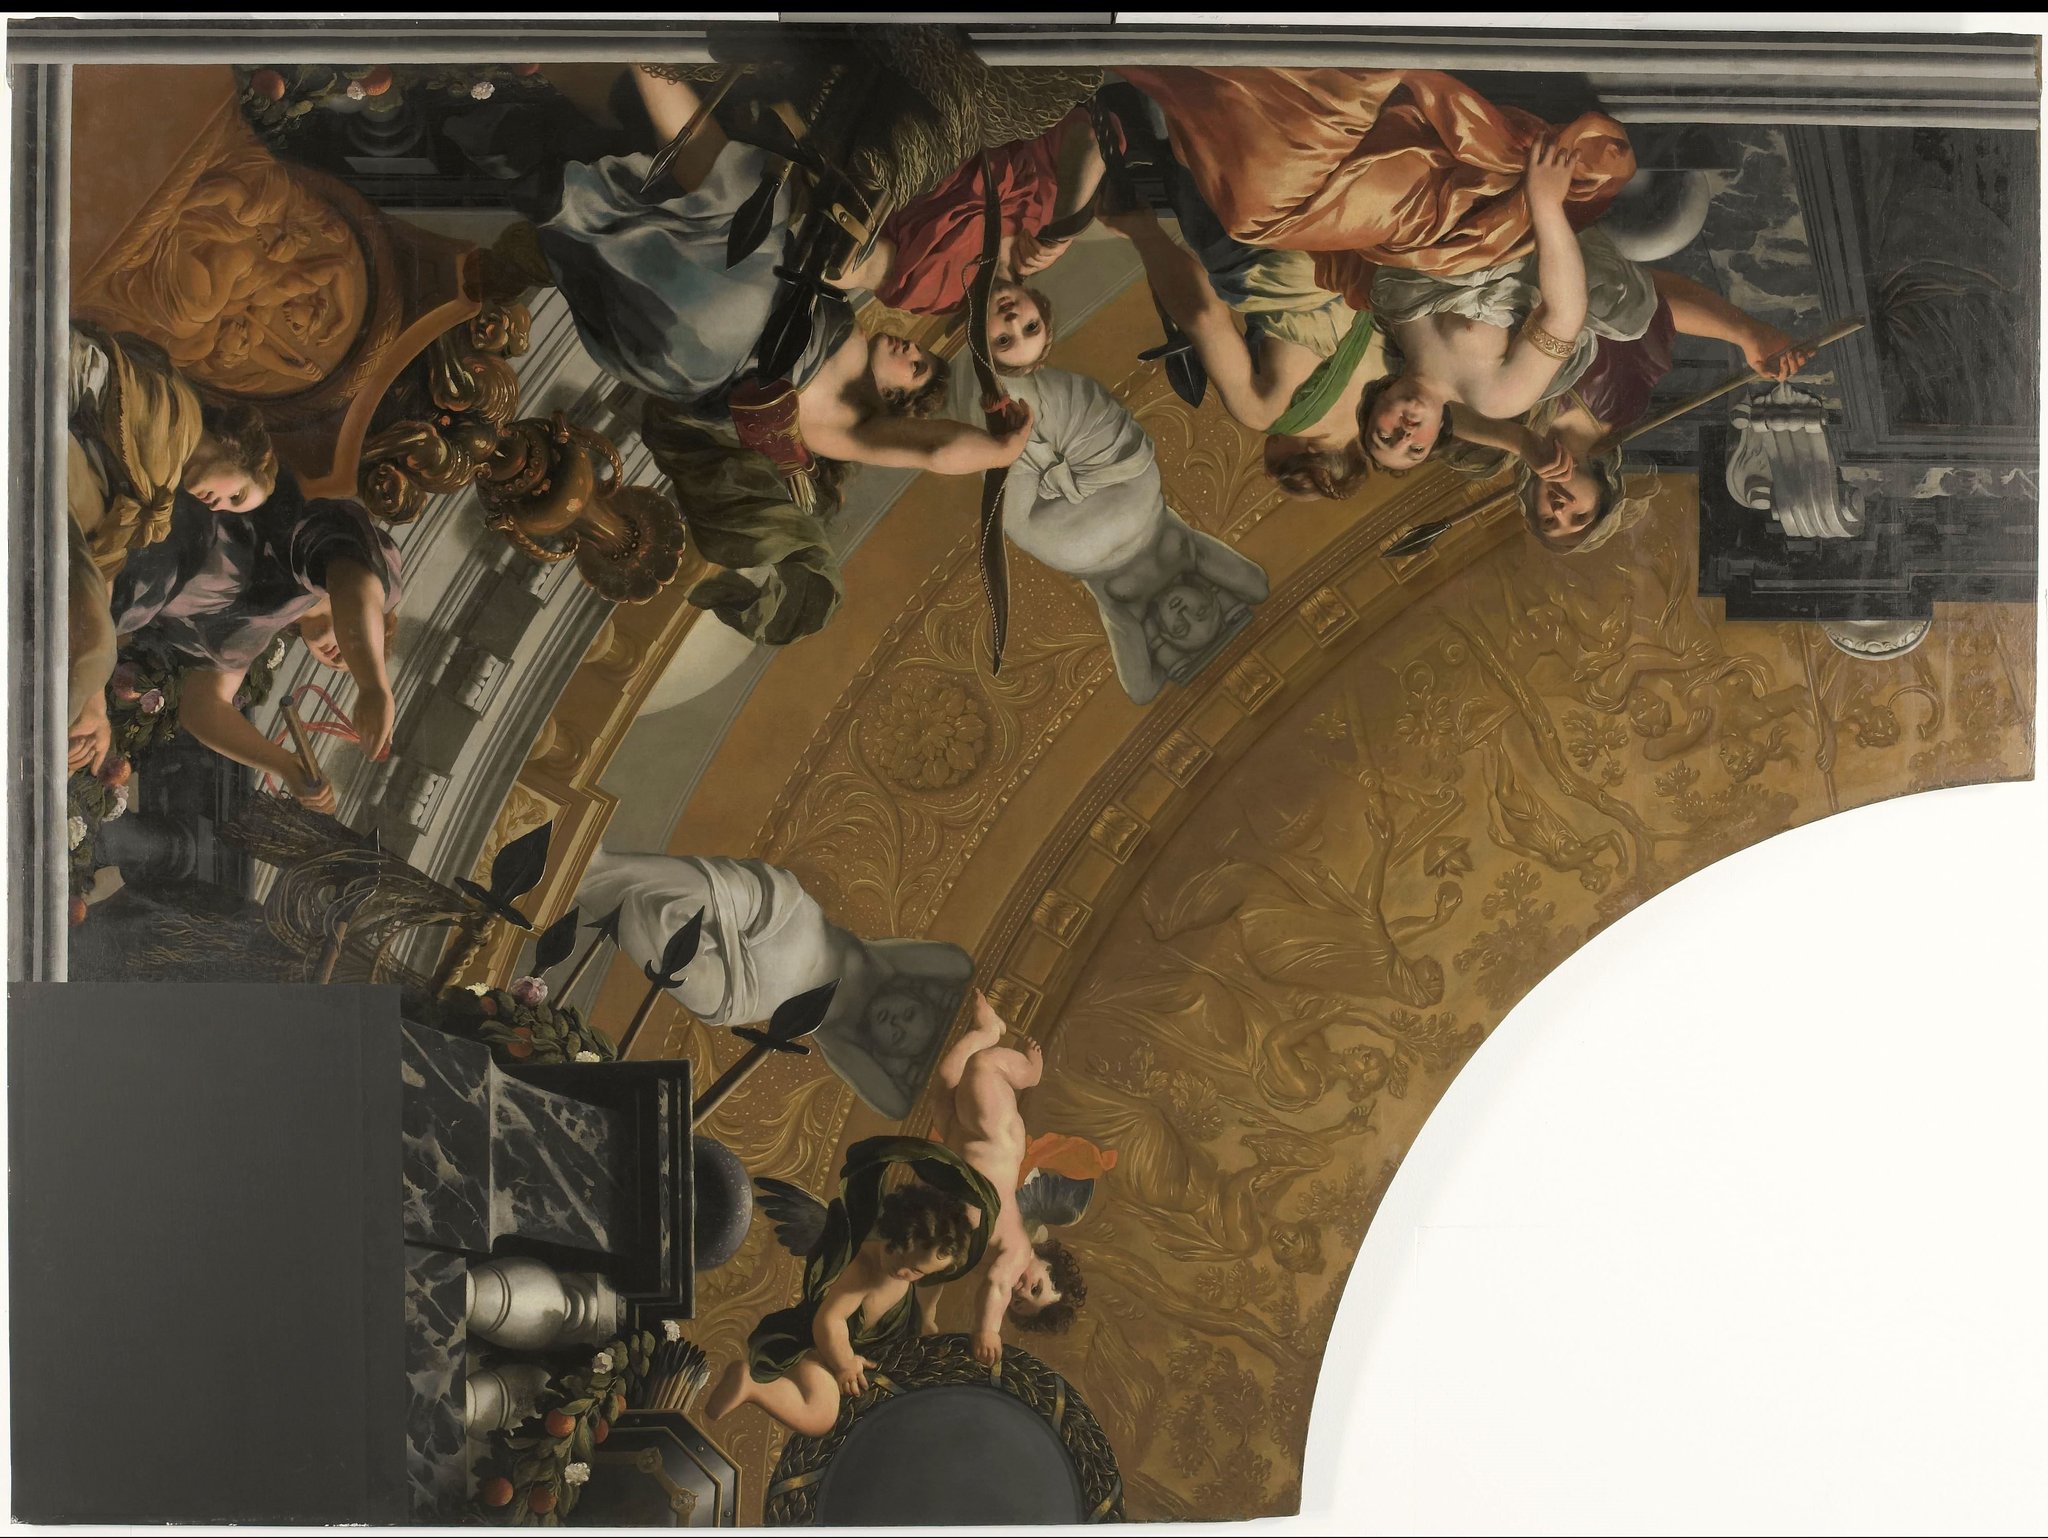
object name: ceiling painting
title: Part (top left) of a ceiling decoration with Diana and her companions as the principal representation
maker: gerard de lairesse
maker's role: draughtsman, painter, print maker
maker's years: 1641-1711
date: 1676-1682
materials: canvas, oil, paint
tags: (story of) diana (artemis)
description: Onderdeel (linksboven) van een plafondschildering van vijf delen met als hoofdvoorstelling Diana en haar gezellinnen, geschilderd voor de 'grote zaal' van Paleis Soestdijk.